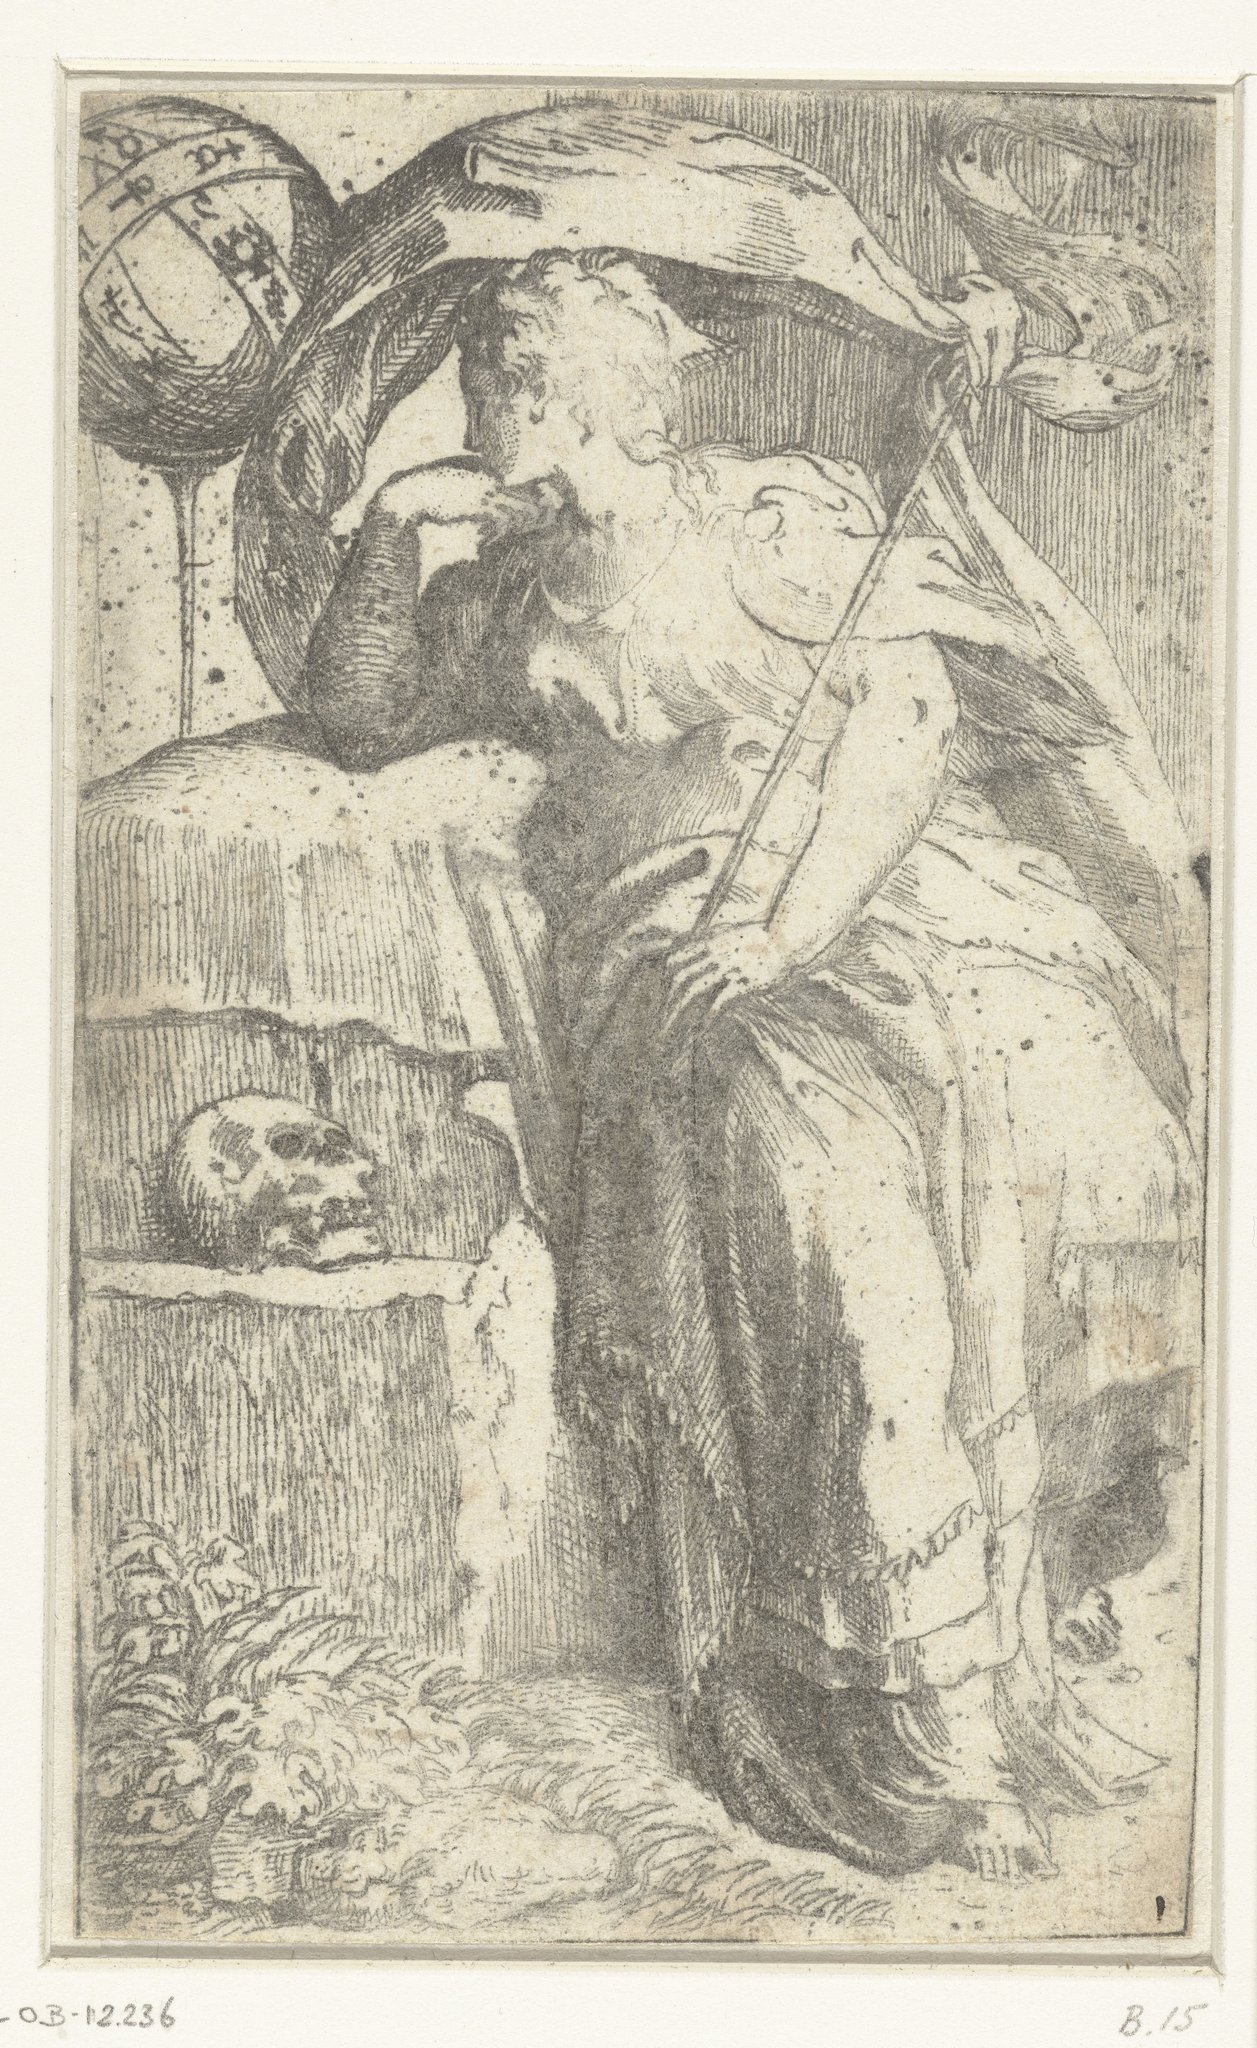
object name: print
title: Astrologie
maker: parmigianino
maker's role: draughtsman, painter, print maker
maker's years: 1503-1540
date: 1513-1540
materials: paper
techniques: drypoint, etching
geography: italy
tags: 'astrologia' (ripa)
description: Personificatie van de Astrologie. Een vrouw, zittend op een rotsblok en in haar hand een staf met een doek er omheen geknoopt. Naast haar een bol met de sterrenbeelden en een schedel.